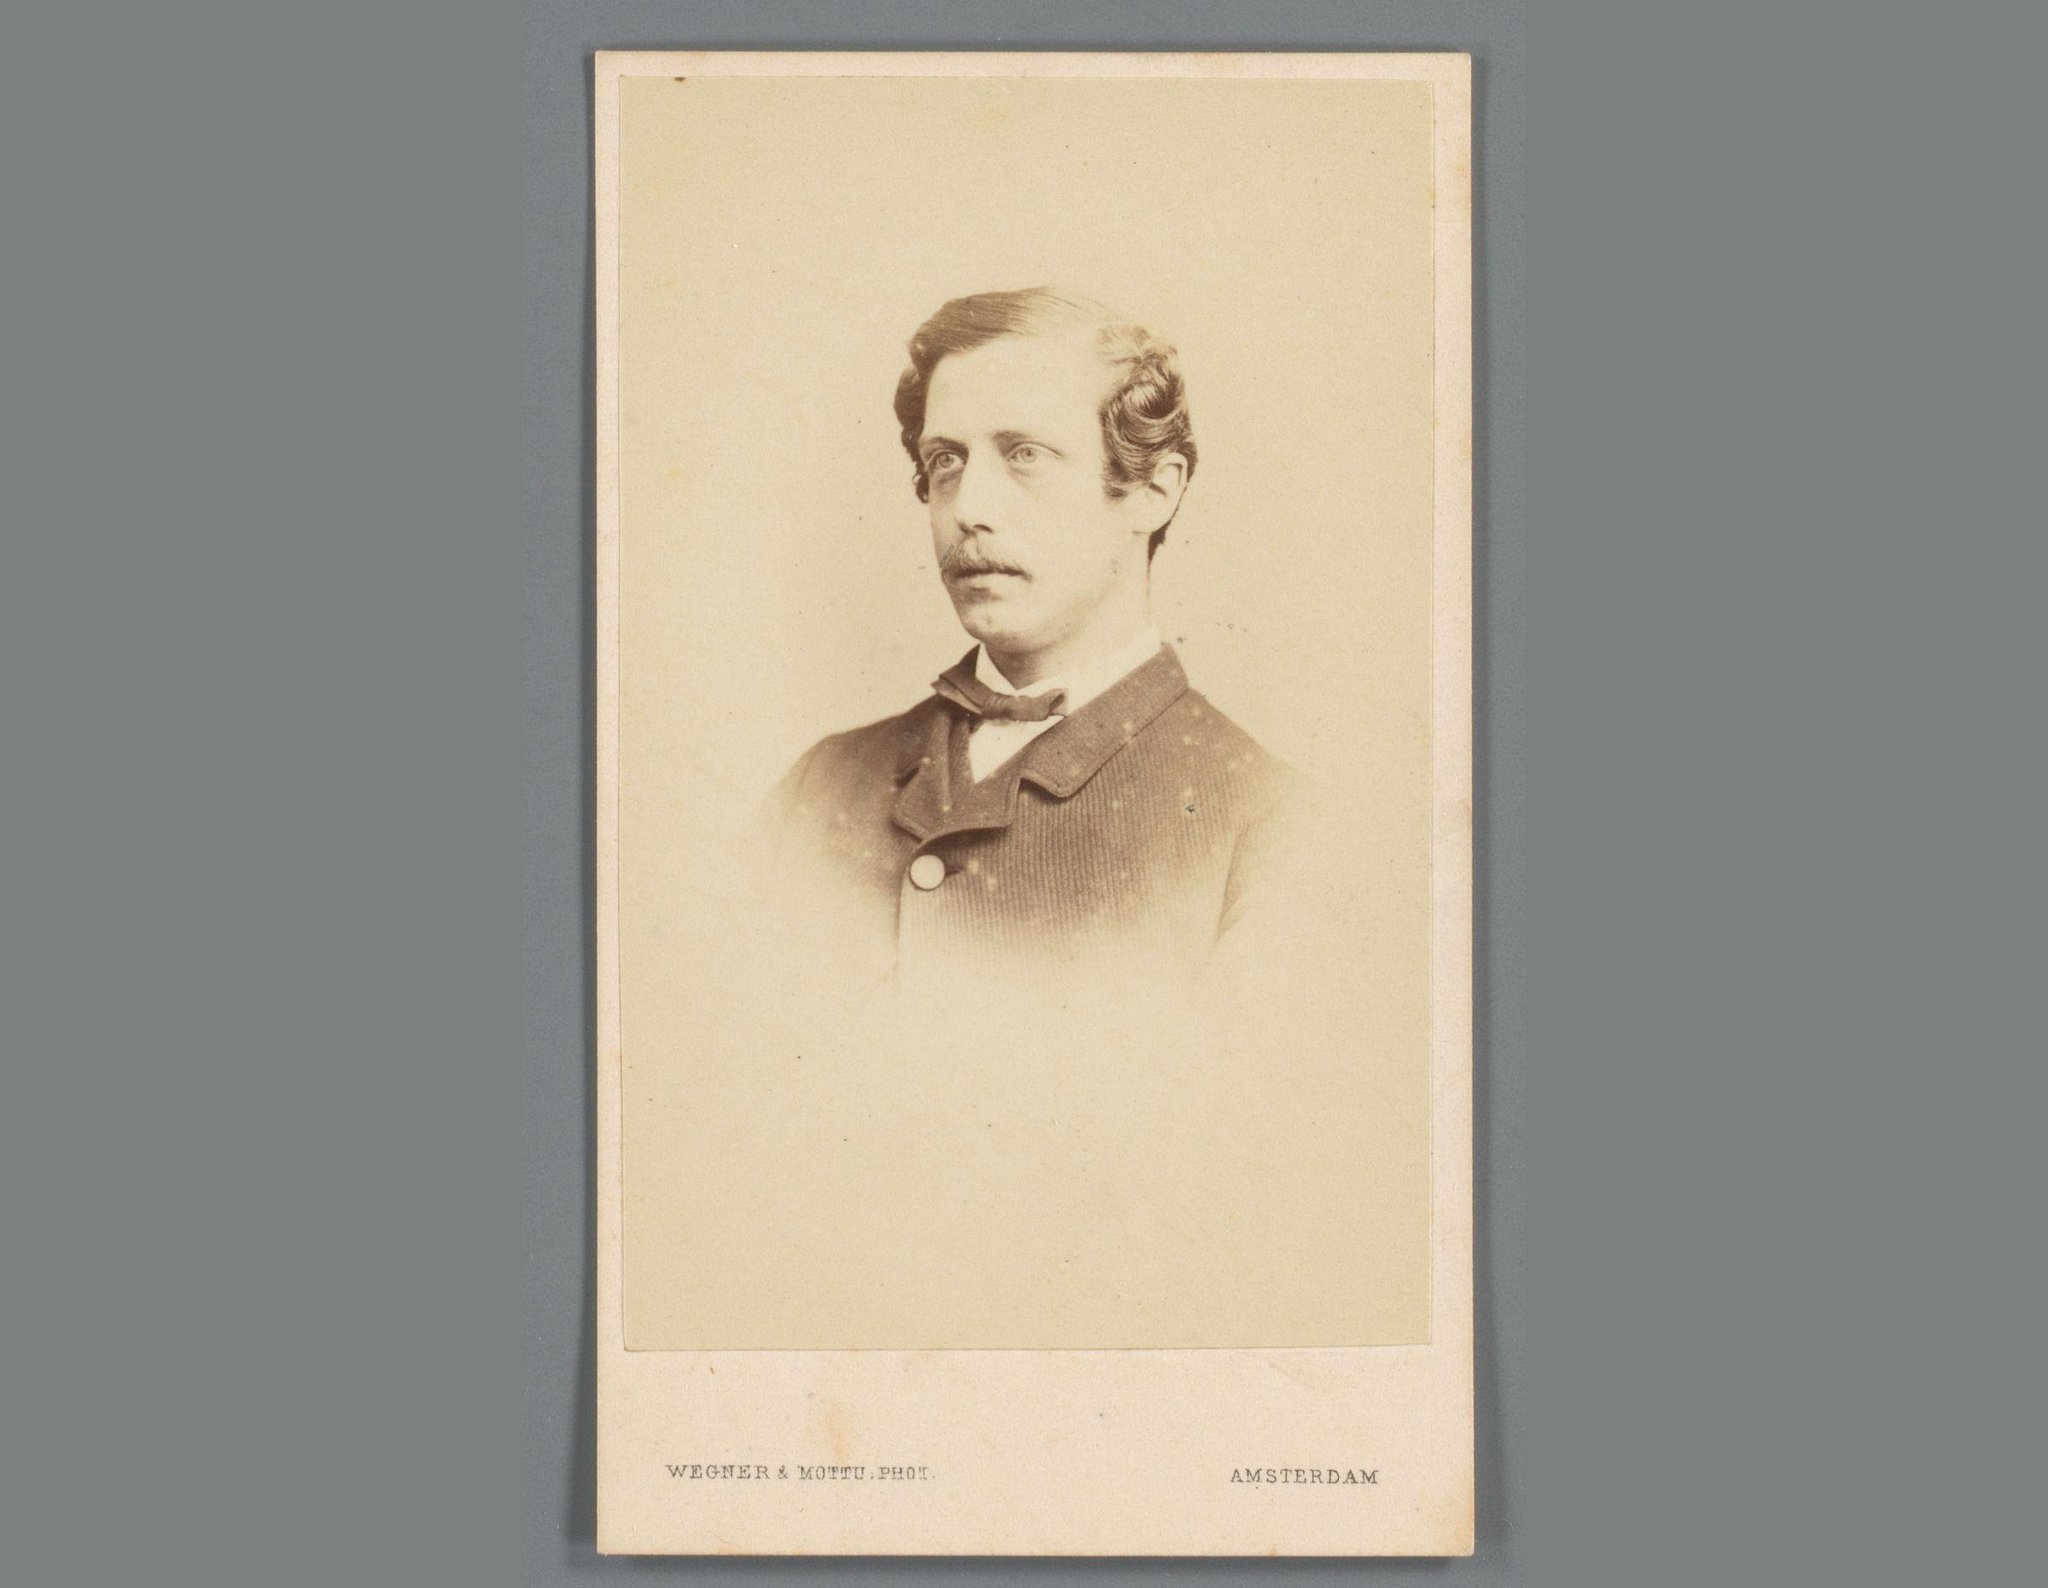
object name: photograph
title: Portret van een onbekende man uit de familie en de kring van Eugene van Delden en Belle van Delden-Denninghof Stelling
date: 1865-1875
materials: cardboard, paper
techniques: albumen print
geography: amsterdam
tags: historical persons not known by name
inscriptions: inscription: ‘Photogr. Atelier/ Wegner & Mottu,/ Kalverstraat/ Over den Heyligenweg D. 26/ Amsterdam’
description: Portret uit de kring van Eugene van Delden (Hartapoera, 1865 - Den Haag, 1954) en Belle van Delden-Denninghof Stelling (Batavia, 1870 - Den Haag, 1947).